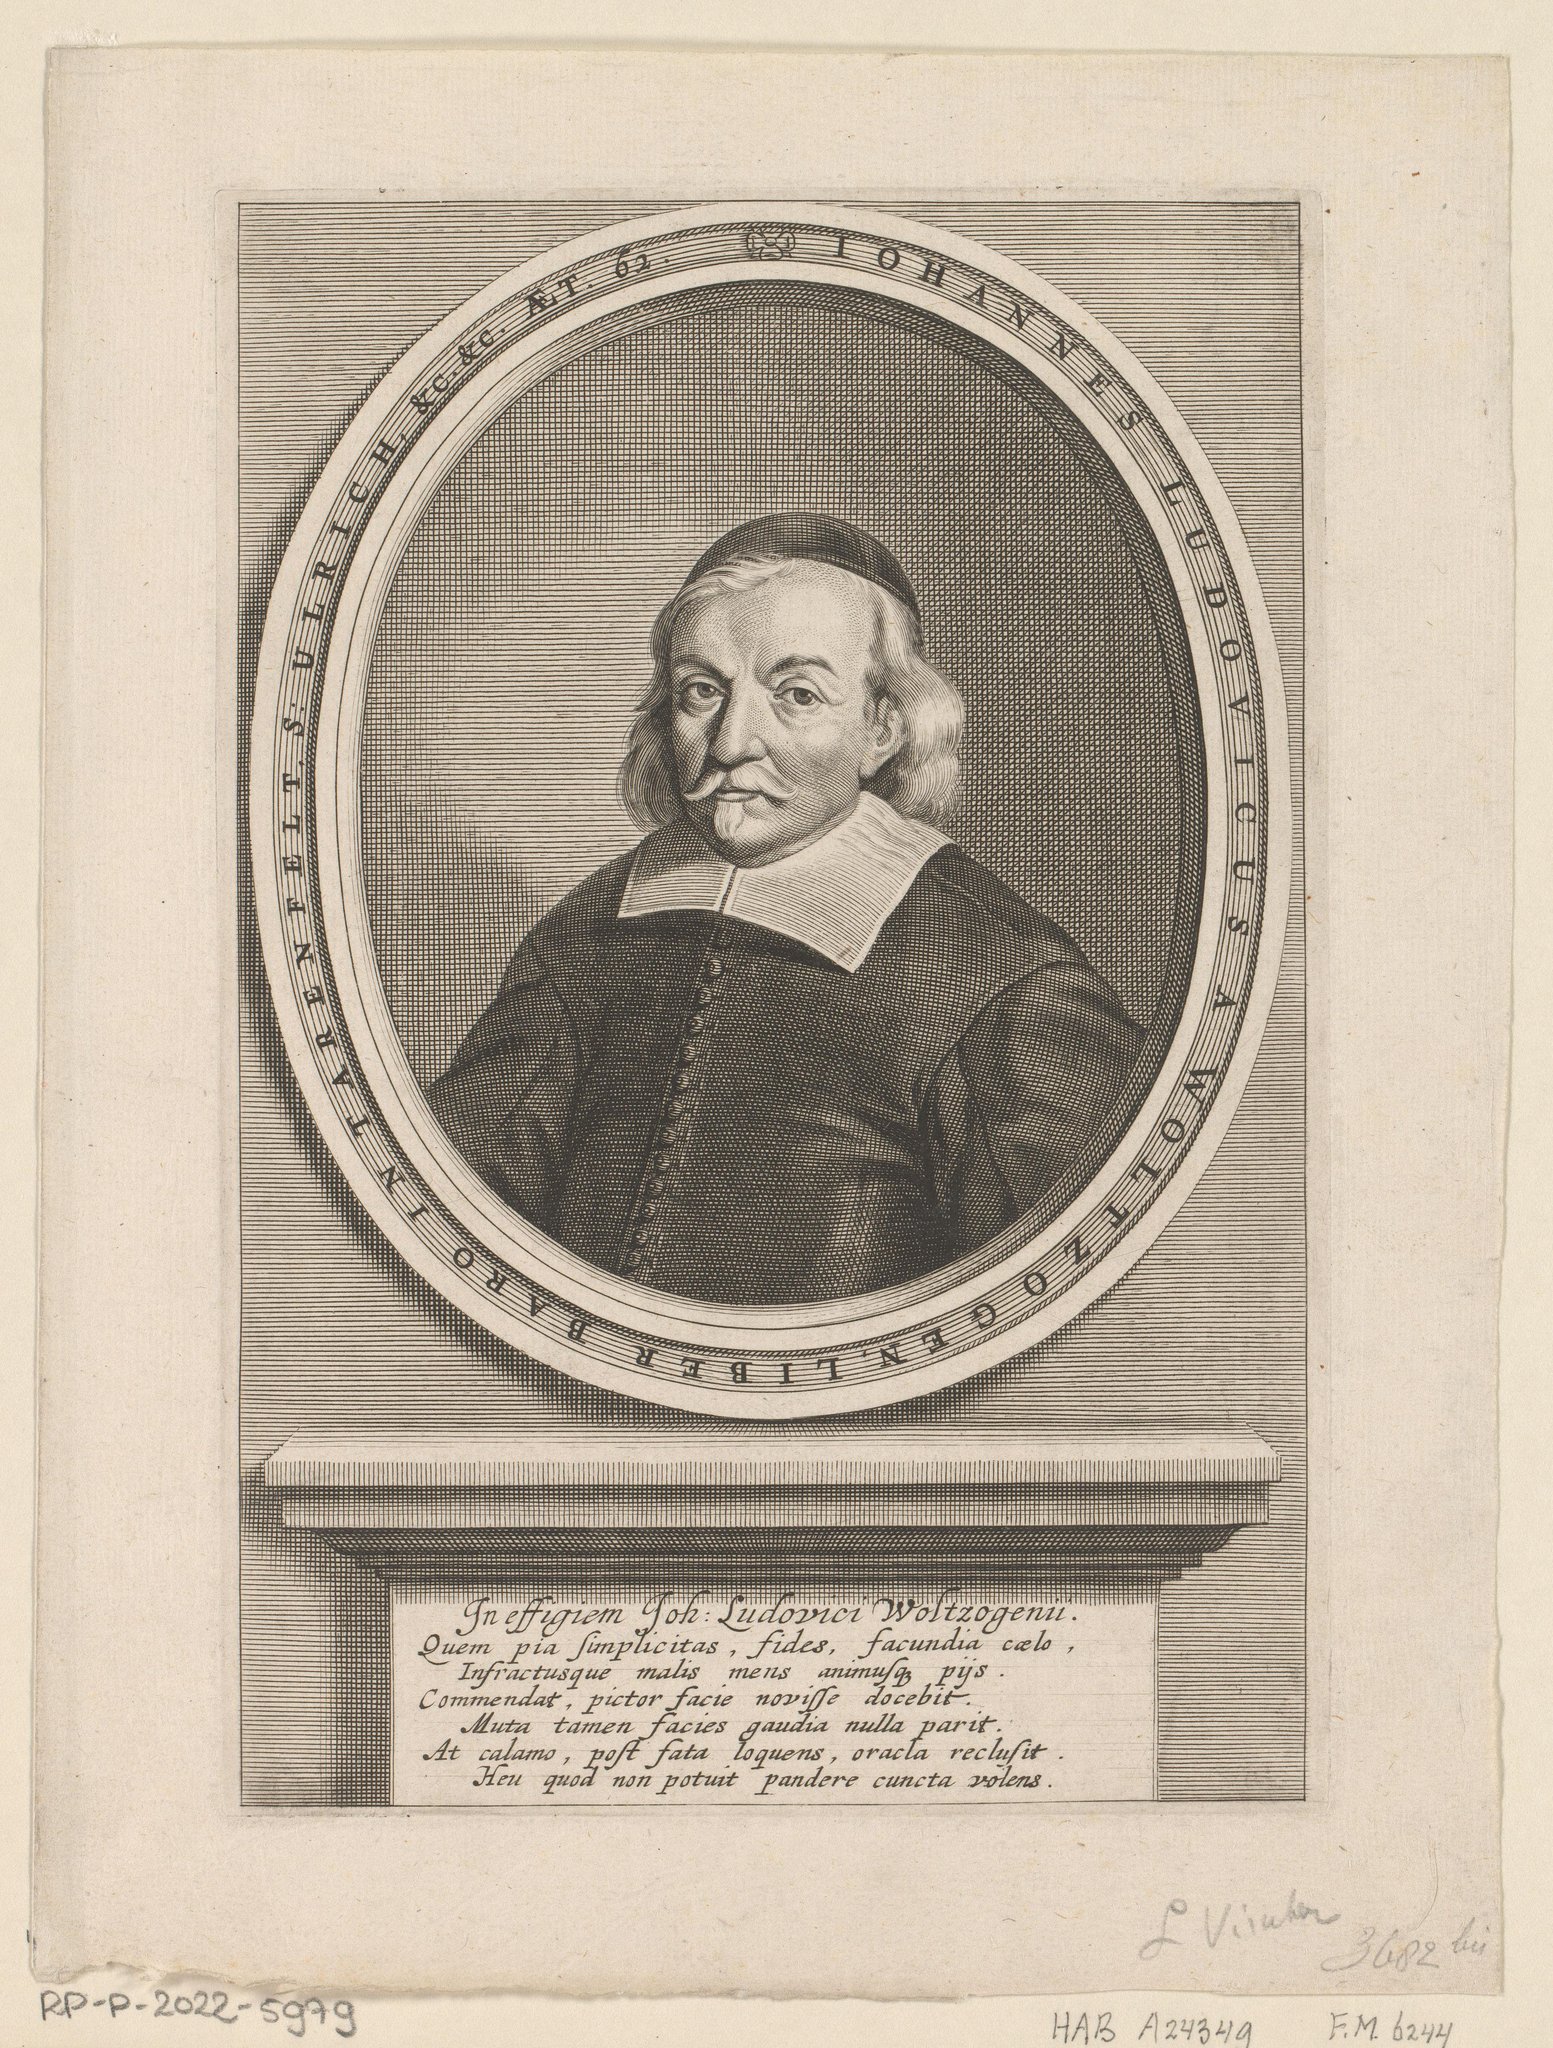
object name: print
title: Portret van Johann Ludwig von Wolzogen op 62-jarige leeftijd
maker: lambert visscher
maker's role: draughtsman, print maker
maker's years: 1640-1679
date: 1656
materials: paper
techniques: engraving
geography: northern netherlands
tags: theologian, scholar, philosopher, historical persons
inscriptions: collector's mark: Lugt 2228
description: Prent waarschijnlijk uit: Wolzogen, Johann Ludwig von. Bibliotheca Fratrum Polonorum (...). S.l.: s.n., 1656.